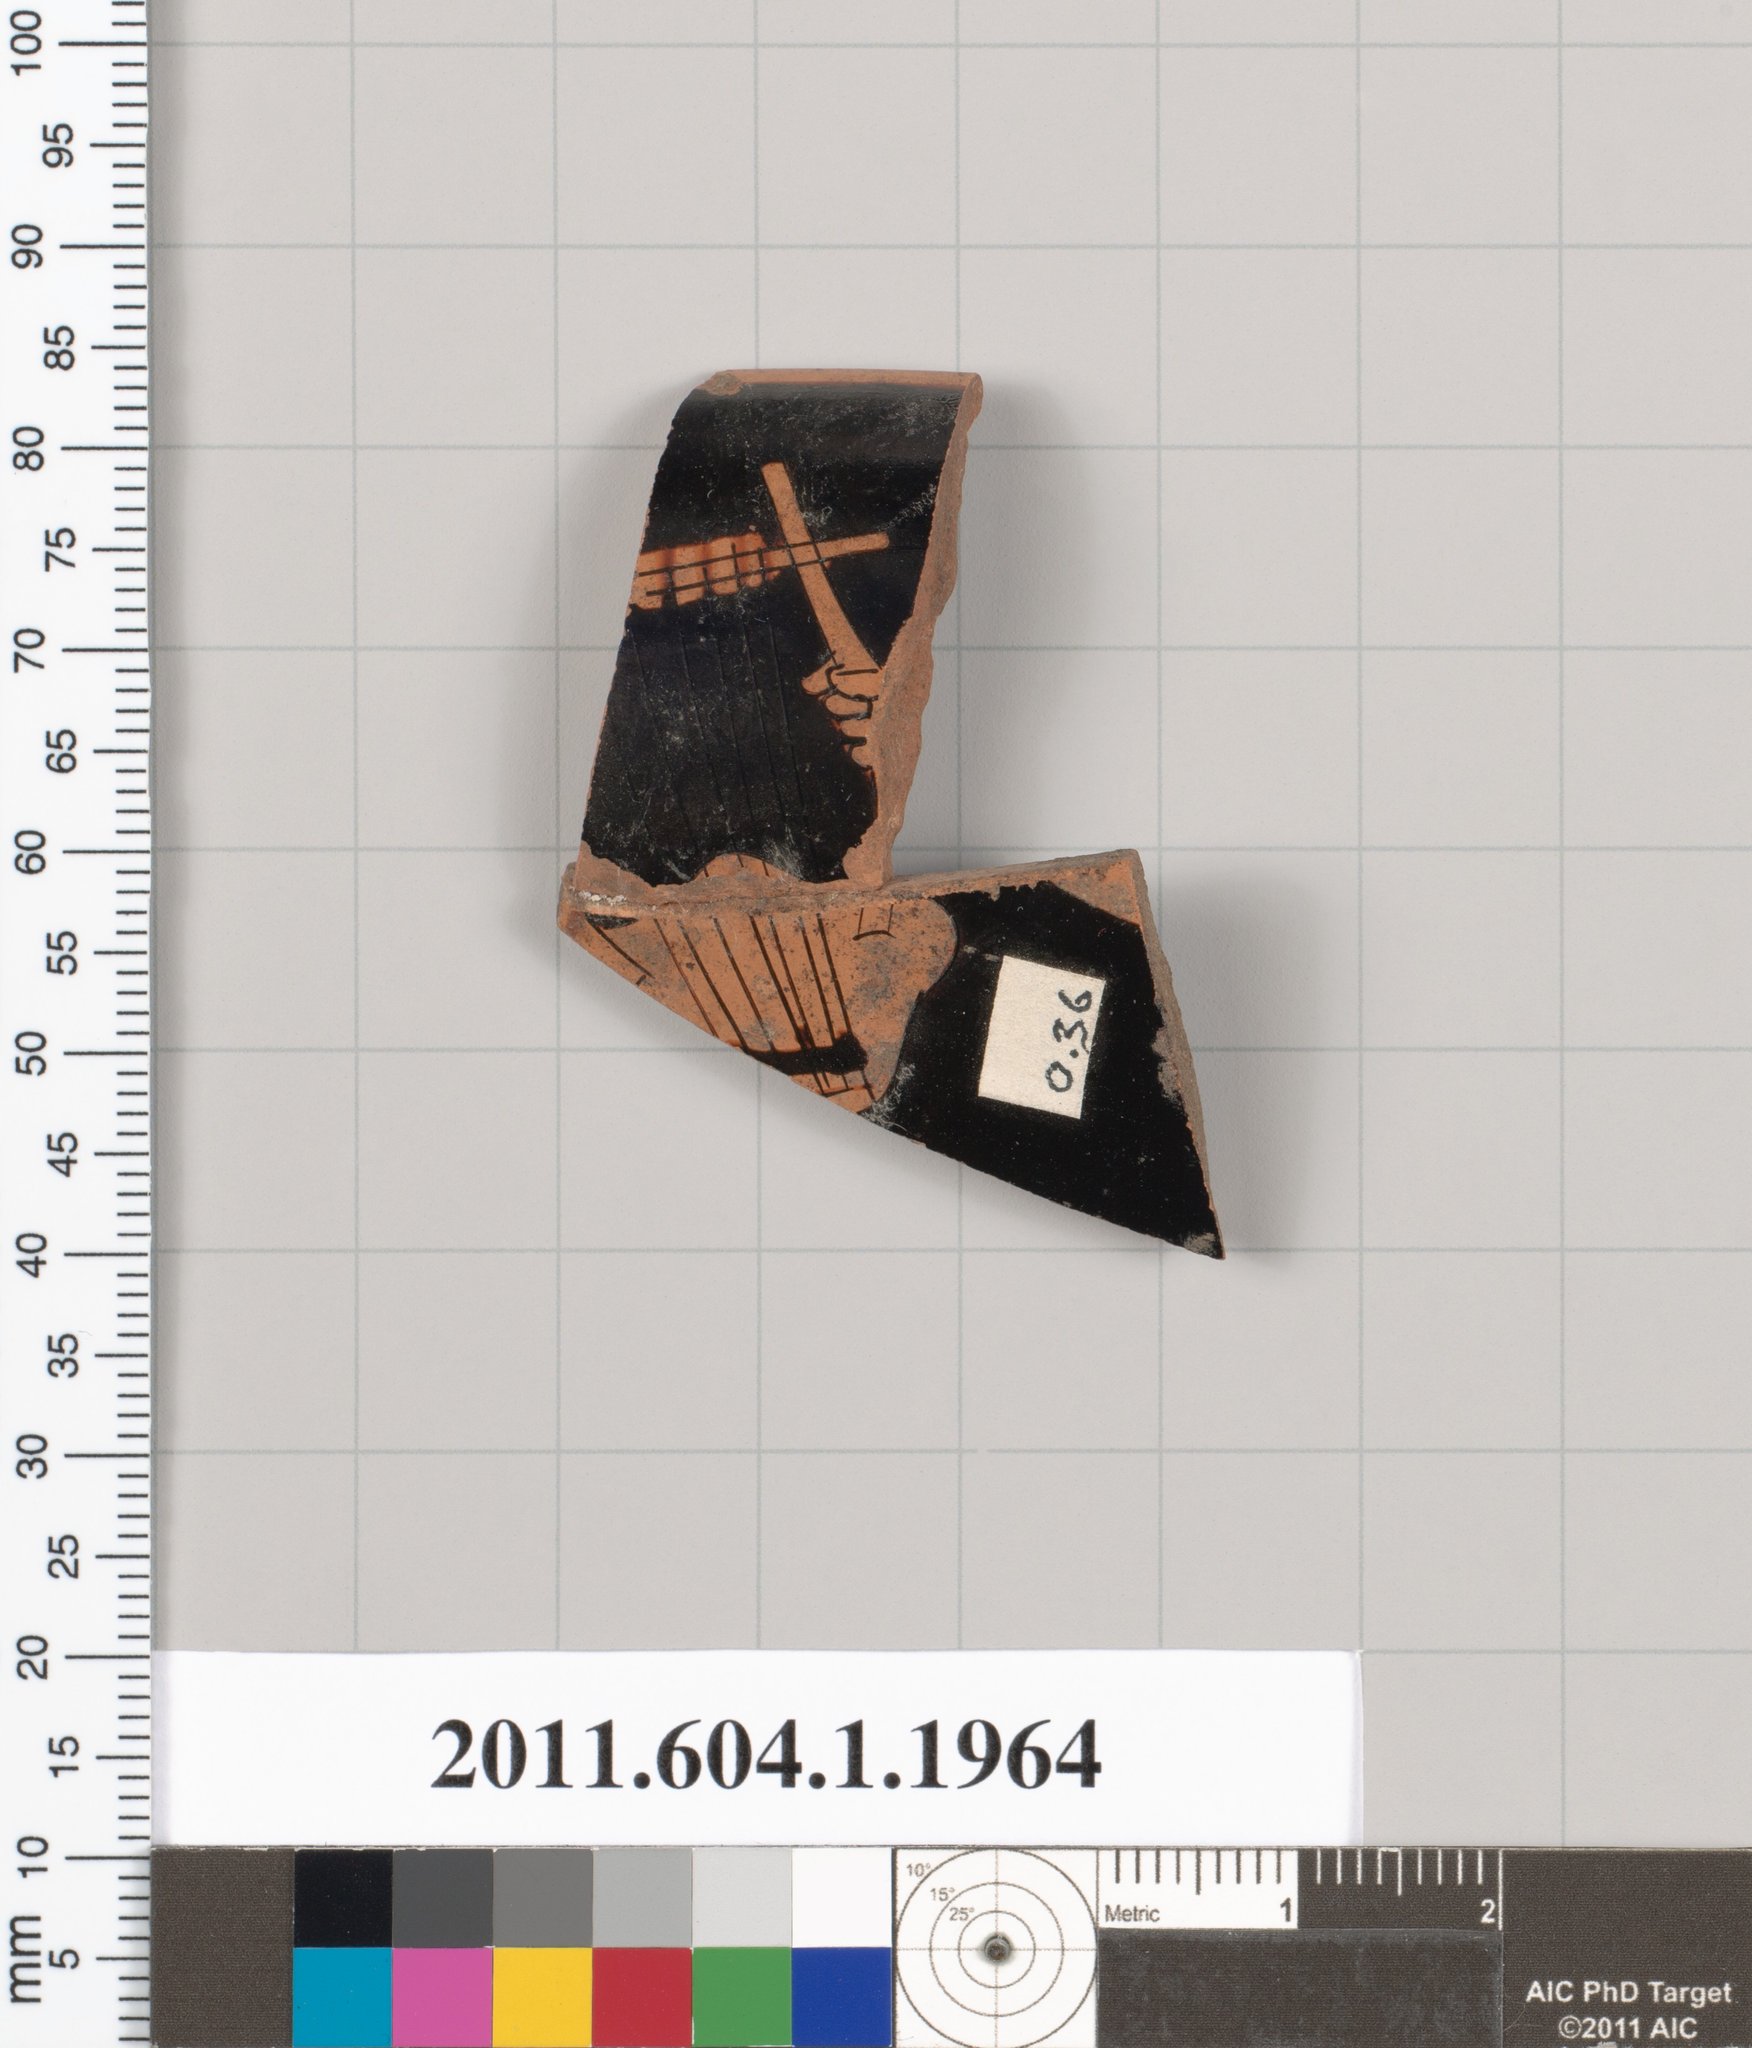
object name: kylix fragment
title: Terracotta rim fragment of a kylix (drinking cup)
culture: greek, attic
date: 475-451 BCE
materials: terracotta